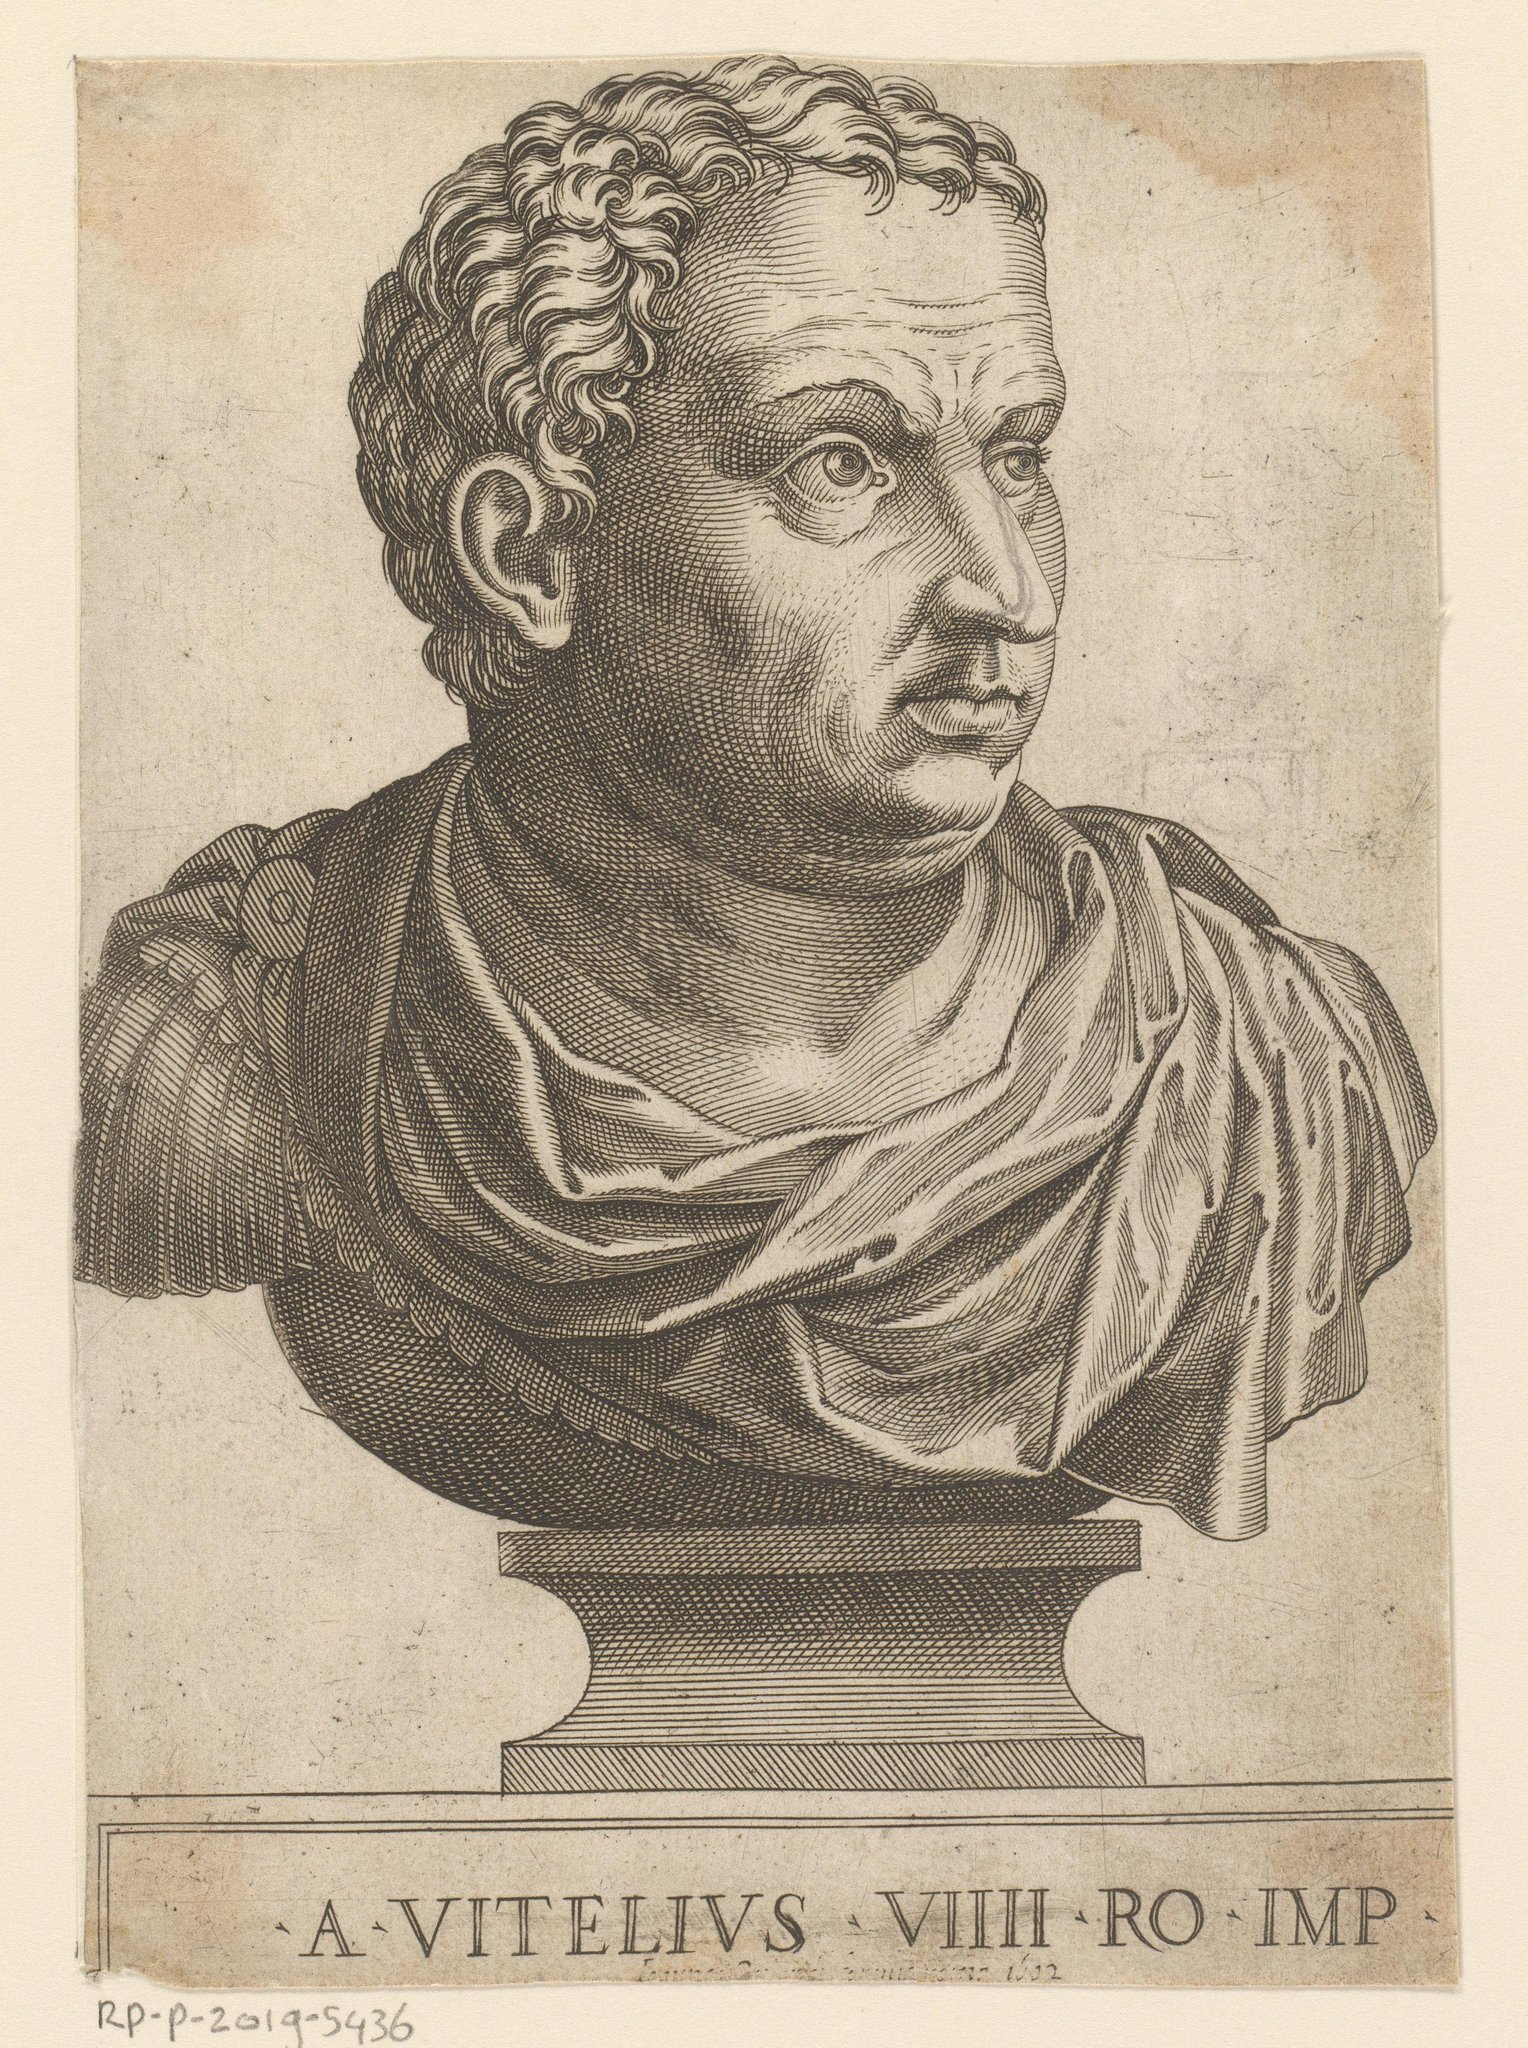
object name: print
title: Keizers van het Romeinse Rijk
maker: martino rota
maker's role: print maker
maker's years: 1520-1583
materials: paper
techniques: engraving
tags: rome, historical persons, emperor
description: Prent voor het eerst gebruikt in de serie 'Imperatorum Caesarumque viginti quatuor effigies a Julio usque ad Alexandrum Severum ex antiquis marmoribus ac numismatis desumptae', gepubliceerd door Claude Duchet (zie documentatie). De prent behoort tot een latere uitgave van deze serie, van een onbekende uitgever.